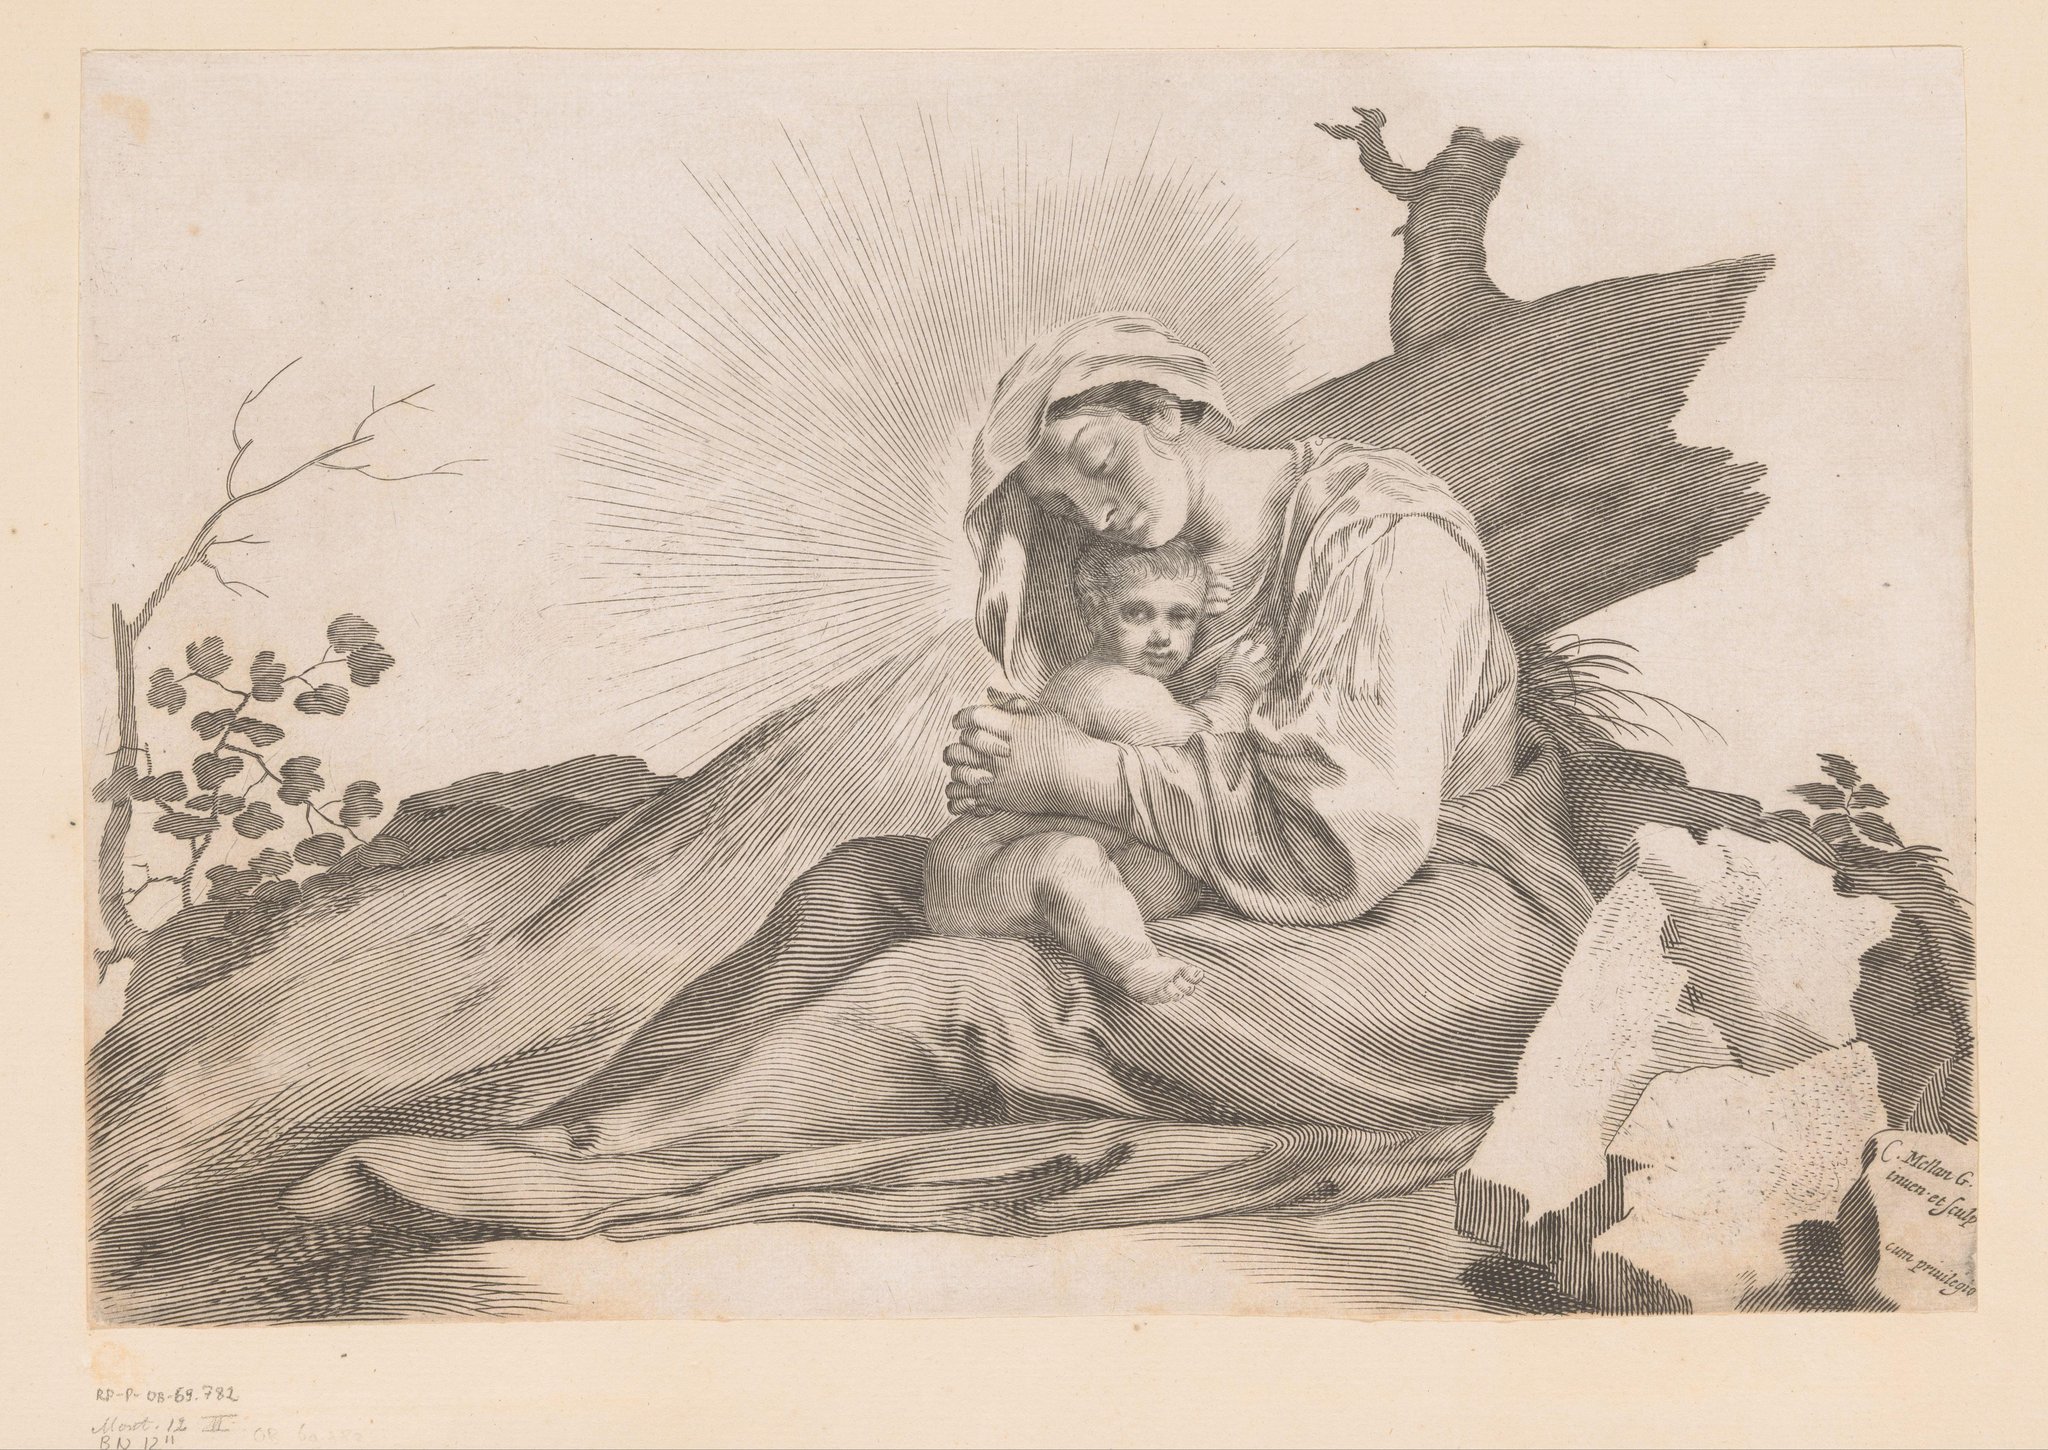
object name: print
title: Maria met Kind bij een boomstronk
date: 1660-1670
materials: paper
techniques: engraving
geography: france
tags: madonna: mary sitting on the ground, the christ-child in her lap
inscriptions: watermark, collector's mark: Lugt 240